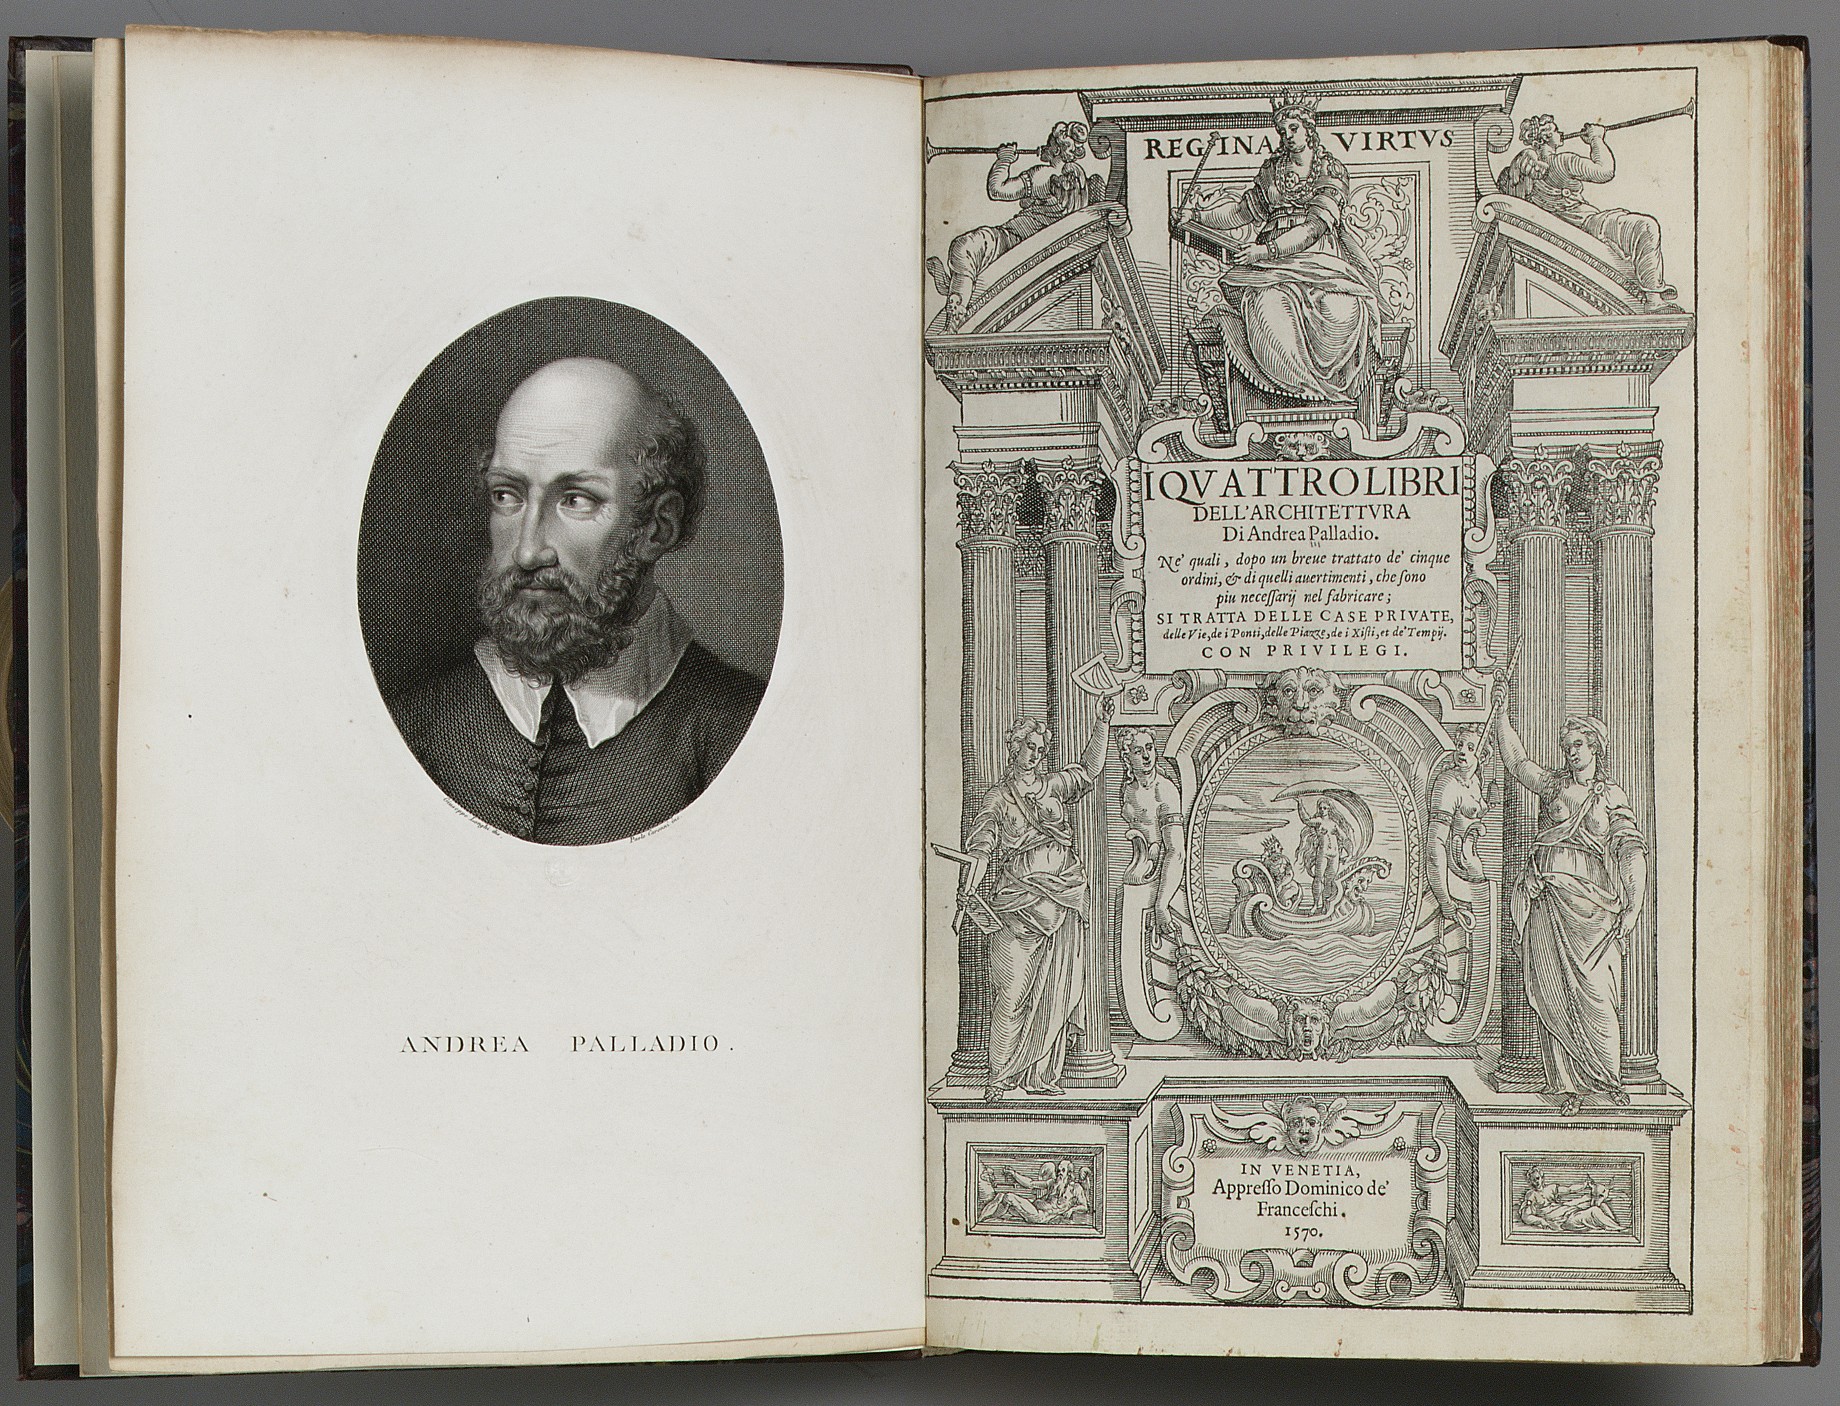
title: I quattro libri dell'architettura di Andrea Palladio . . .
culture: italian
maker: andrea palladio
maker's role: author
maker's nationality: italian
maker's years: 1508-1580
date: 1570